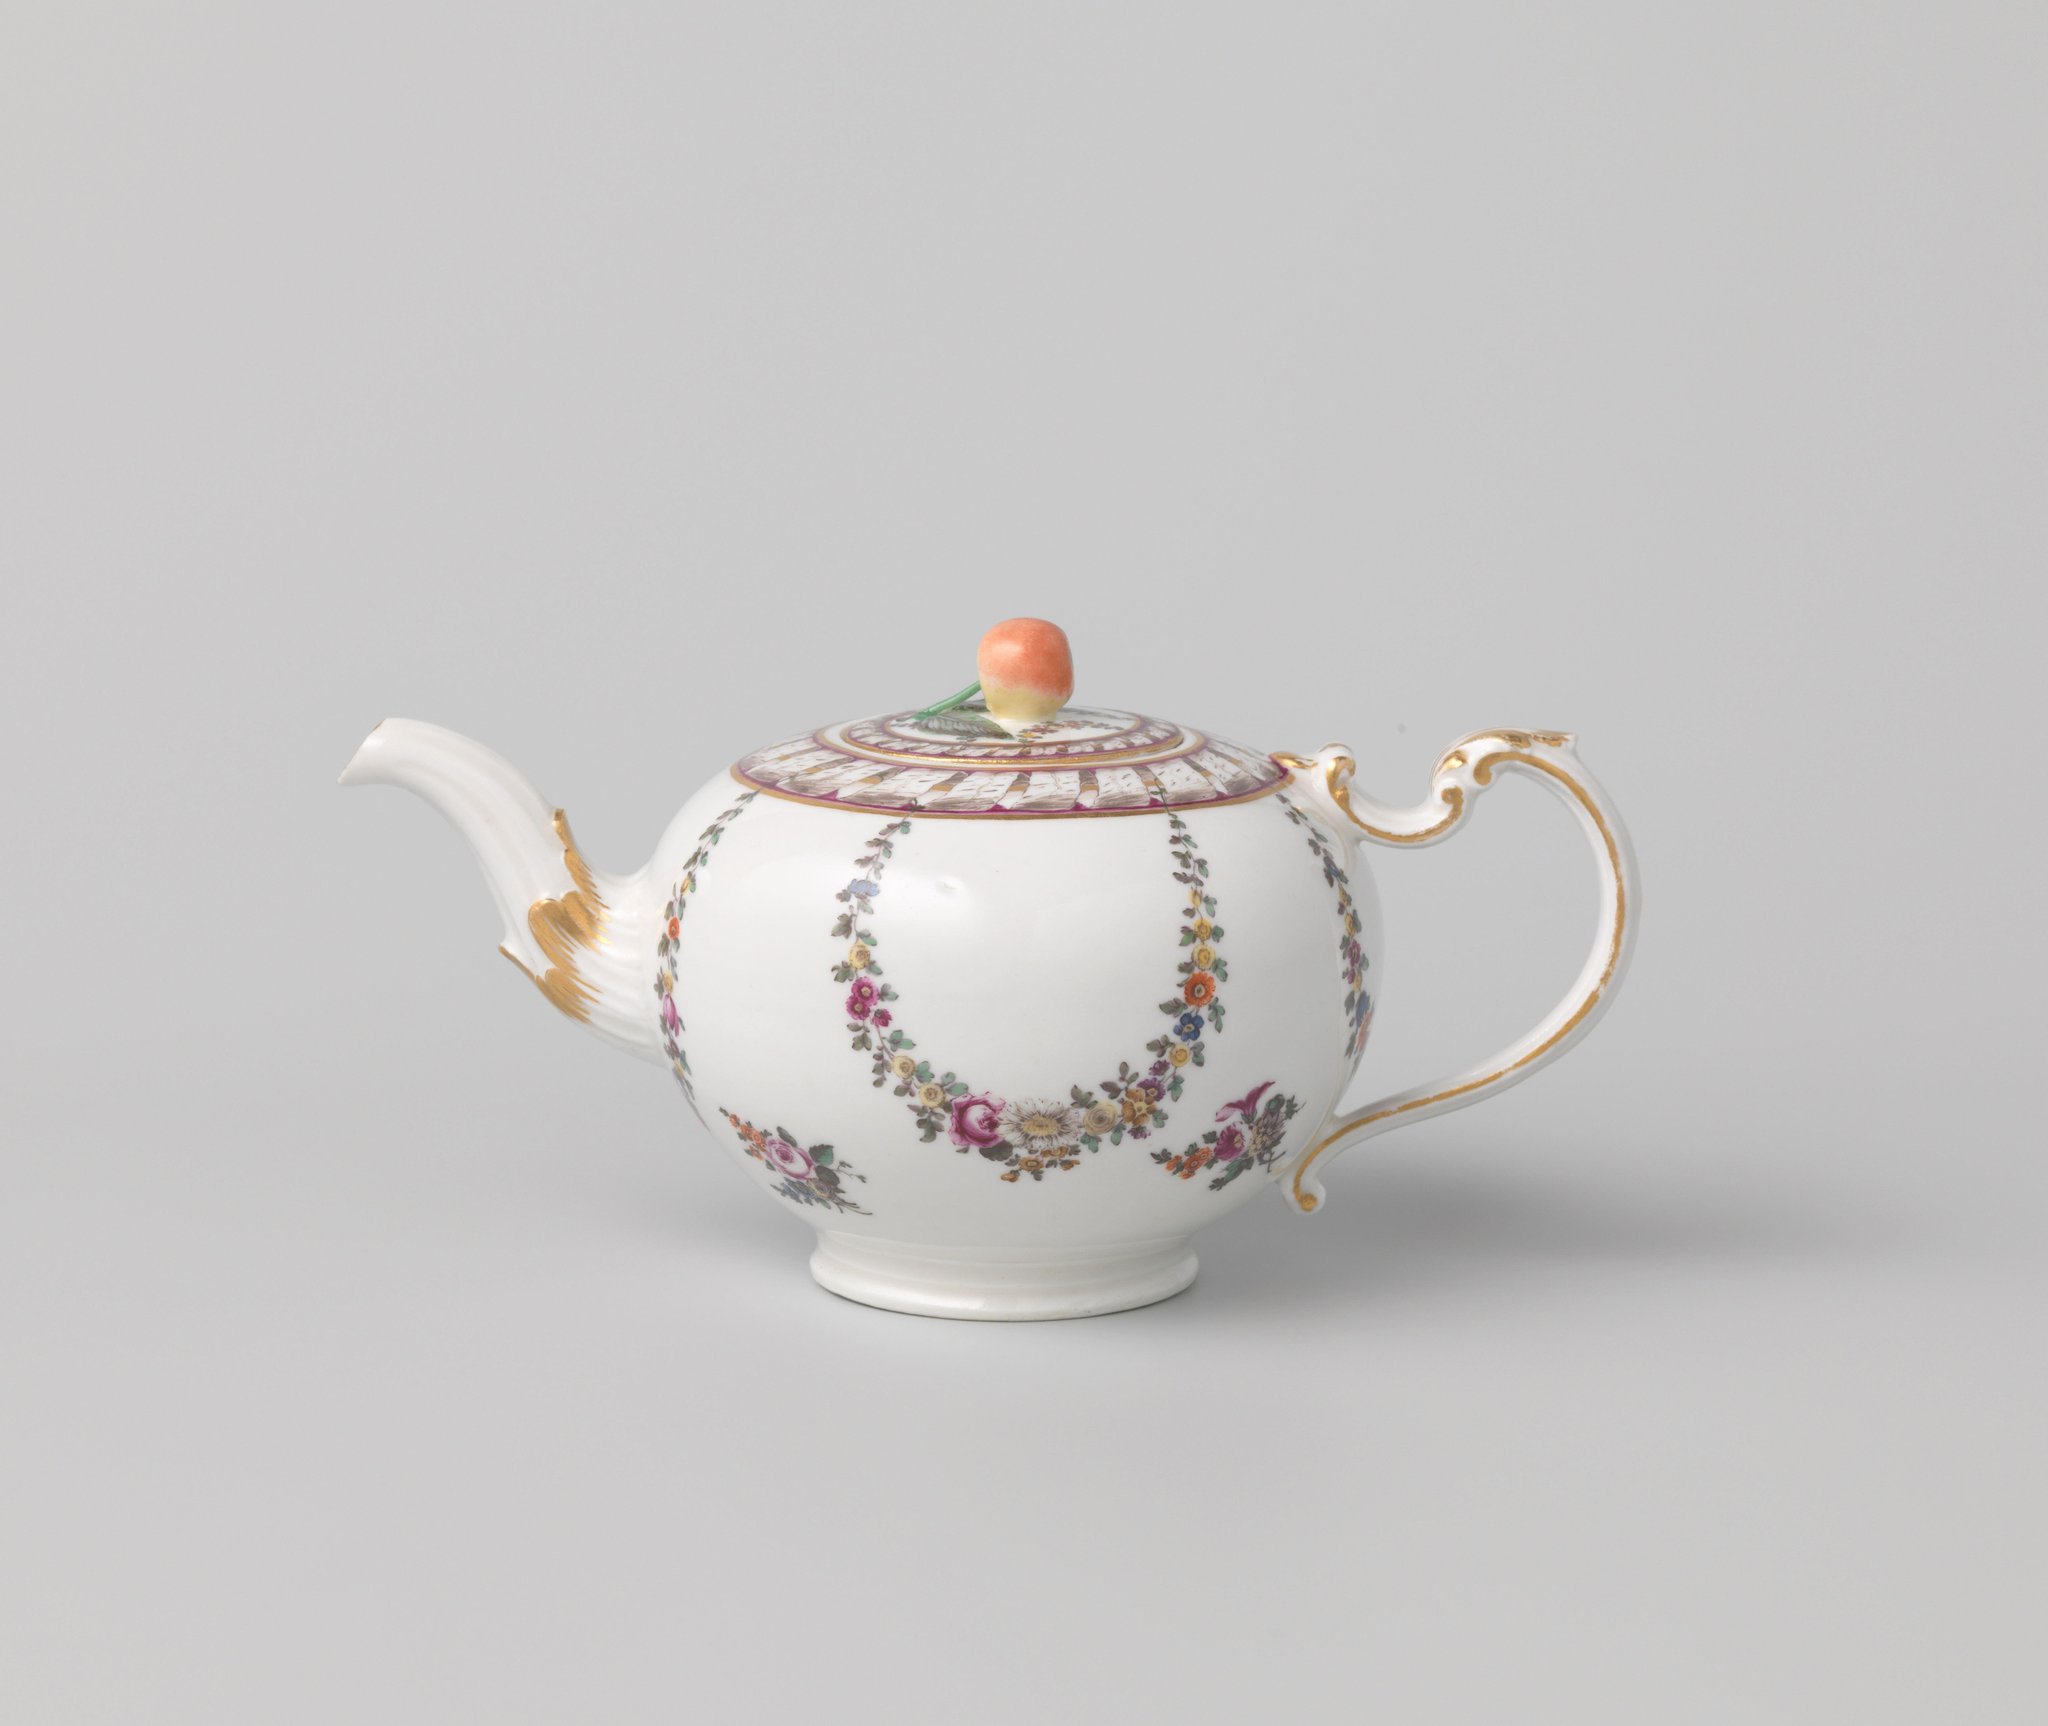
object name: teapot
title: Teapot with bouquets and garlands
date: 1765-1775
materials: glaze, gold, paint, porcelain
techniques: firing, forming, gilding, turning, vitrification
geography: ludwigsburg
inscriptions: mark: ‘gekroonde dubbele C’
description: Tea pot Porcelain Ludwigsburg, c. 1765 - 1775